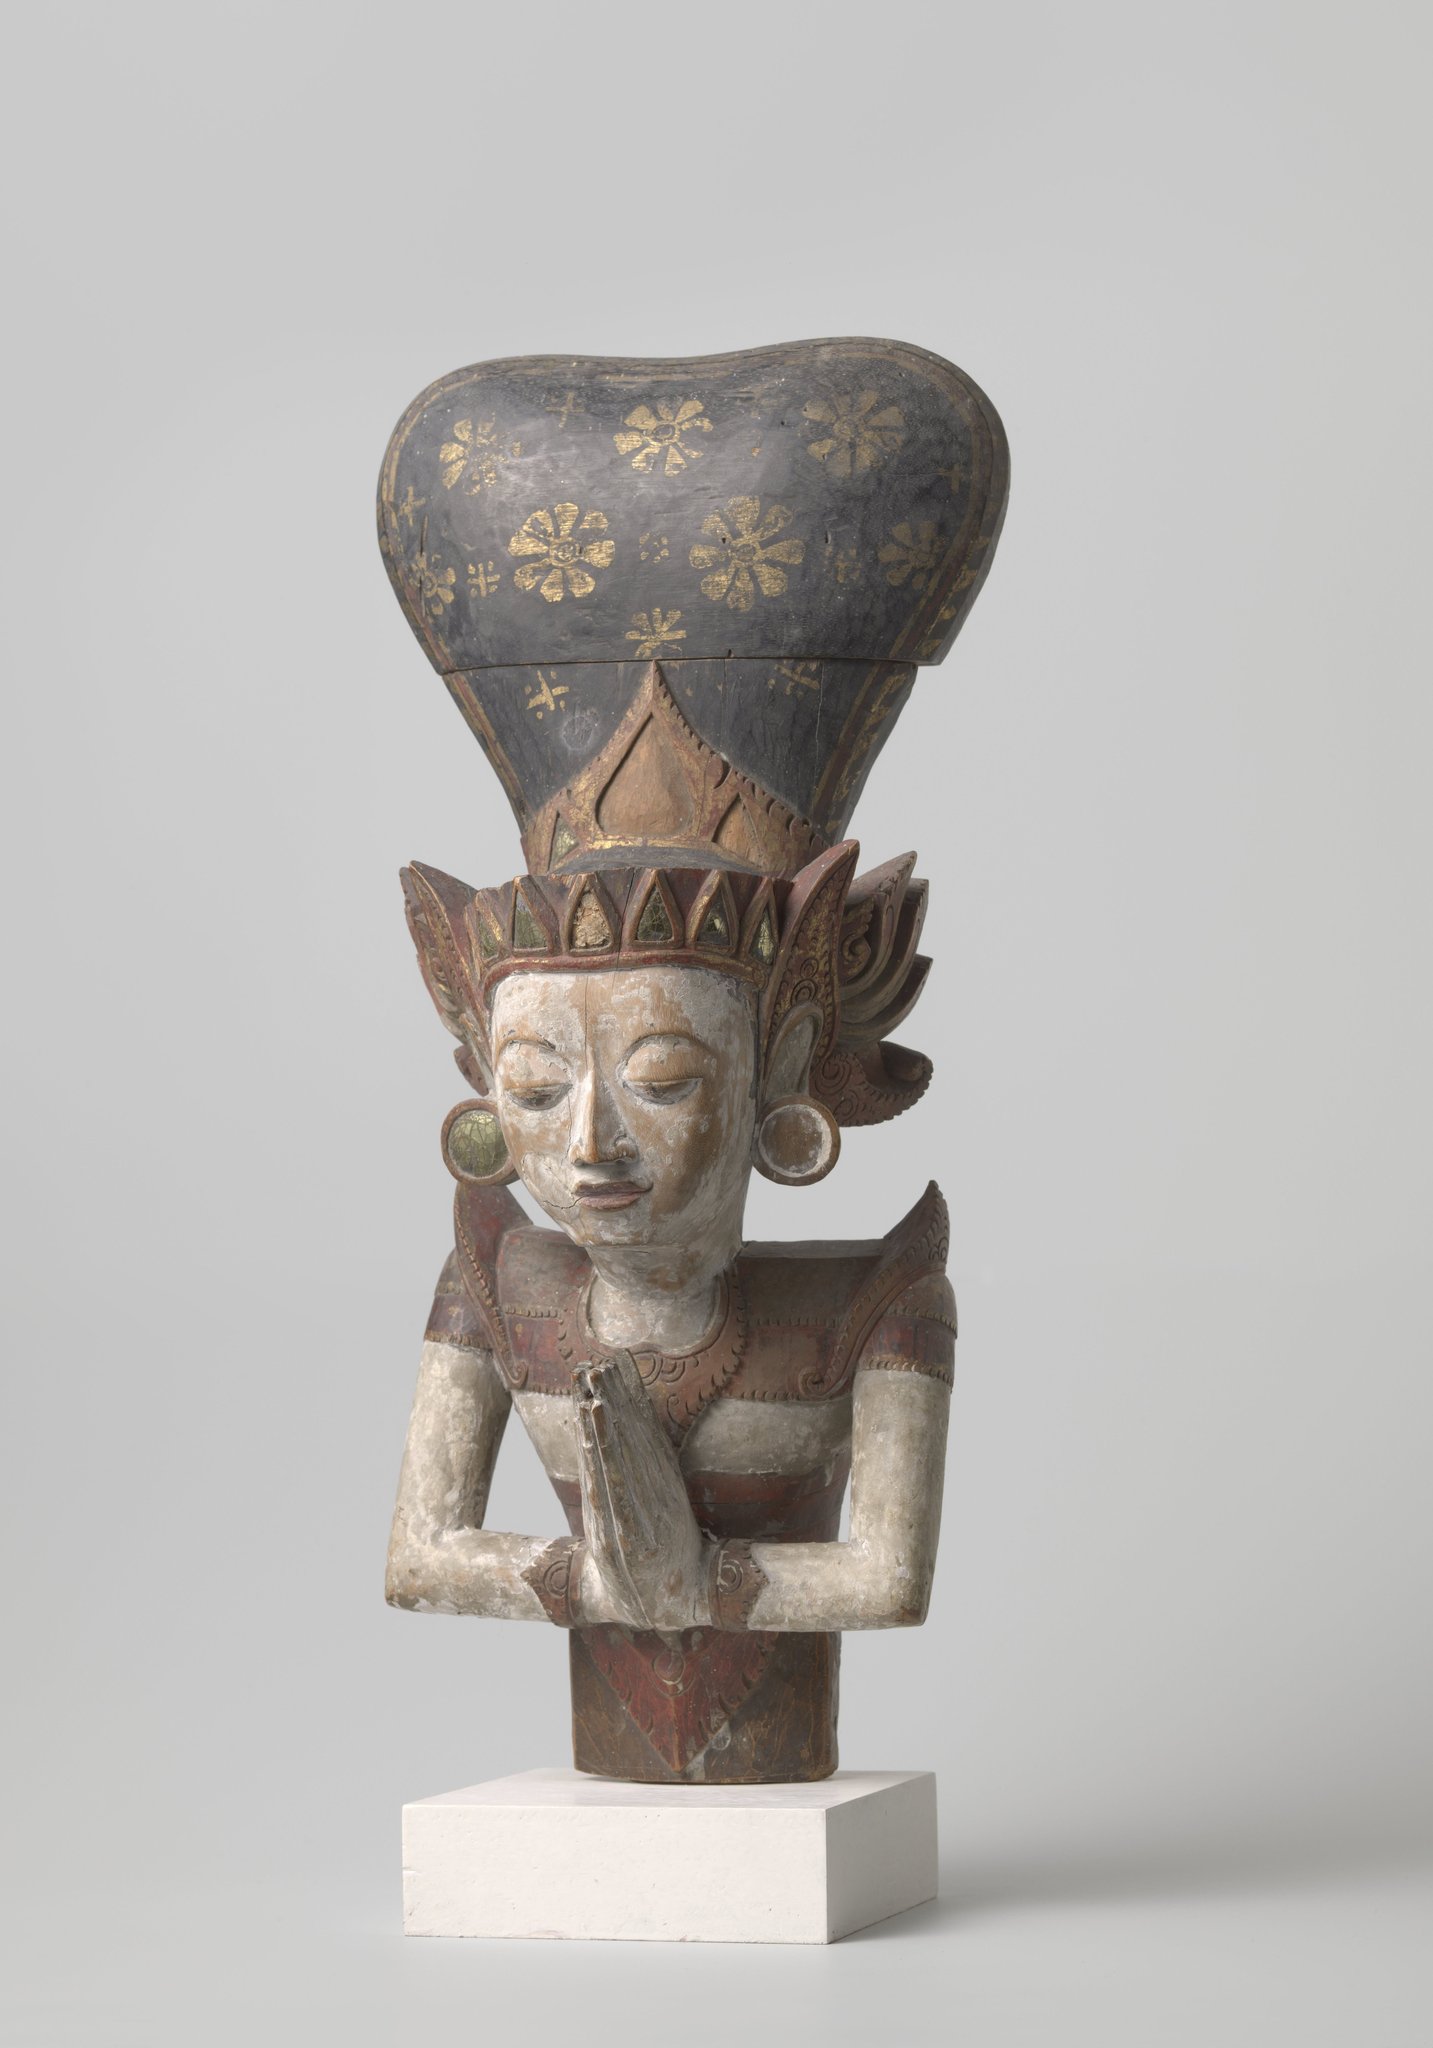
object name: sculpture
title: Beeld van een godin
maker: Anonymous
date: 1775-1825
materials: dye, glass, wood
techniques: gilding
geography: bali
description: Godin, houtsculptuur, gedeelten van hoofdtooi en oorsieraden van glas. Op sokkel.